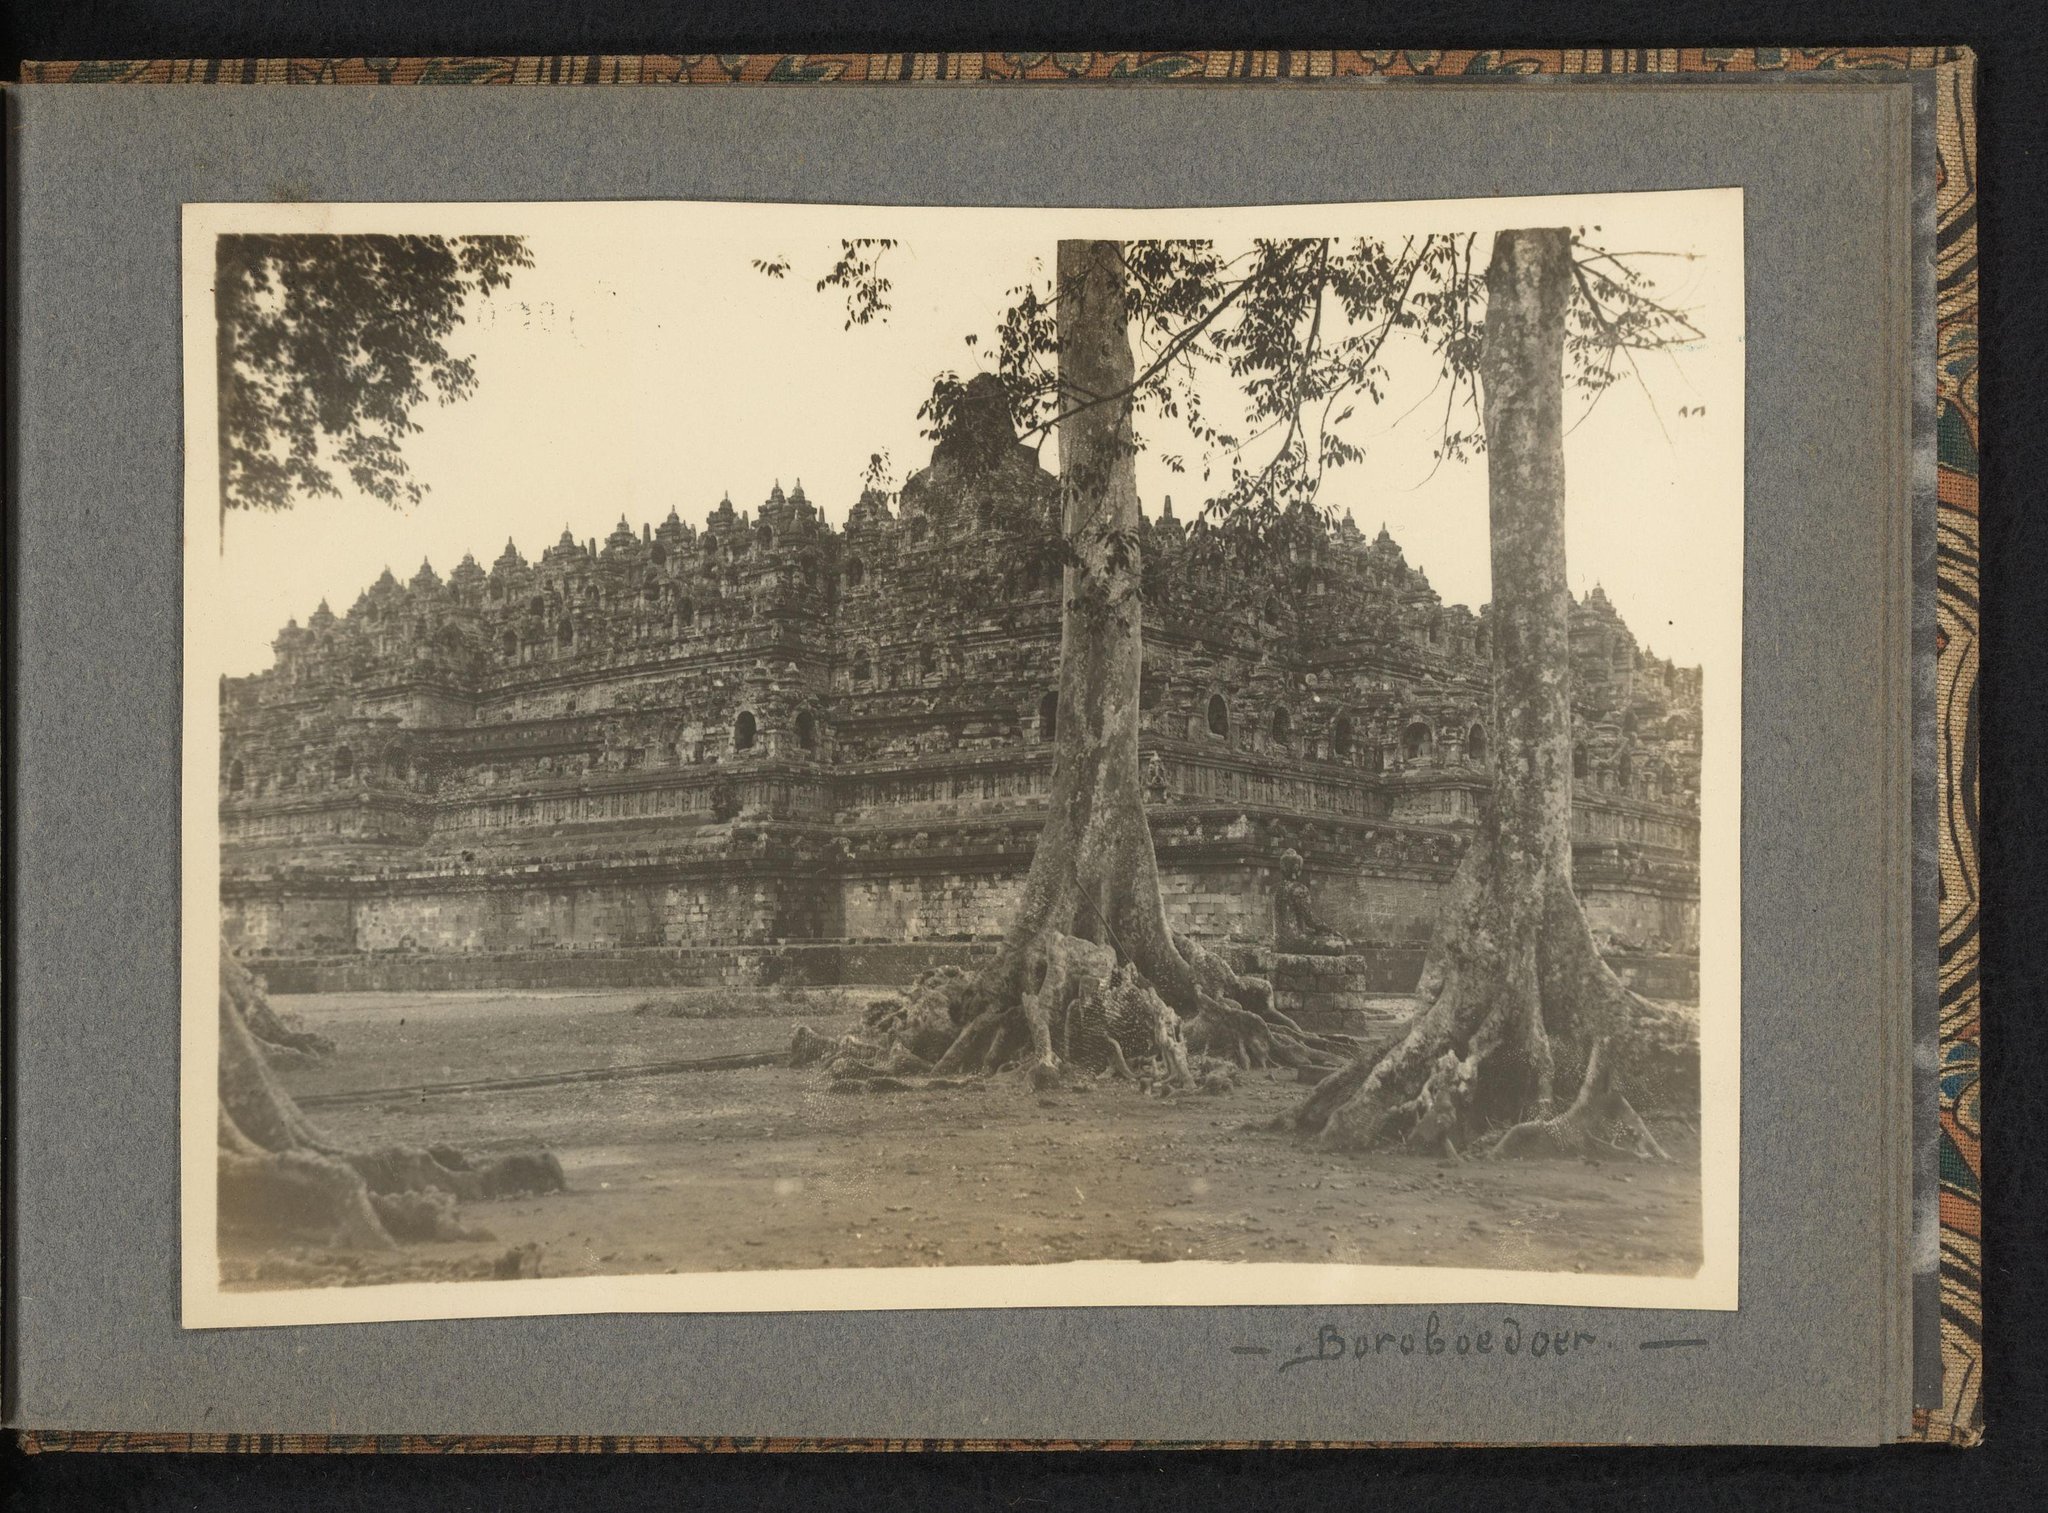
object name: photograph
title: Gezicht op de Borobudur in Midden-Java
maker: karel frederik van den berg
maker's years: 1873-1948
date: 1921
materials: paper, cardboard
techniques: gelatin silver print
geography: central java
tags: temple, shrine ~ hinduism, buddhism, jainism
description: Deze foto's zijn onderdeel van een album.